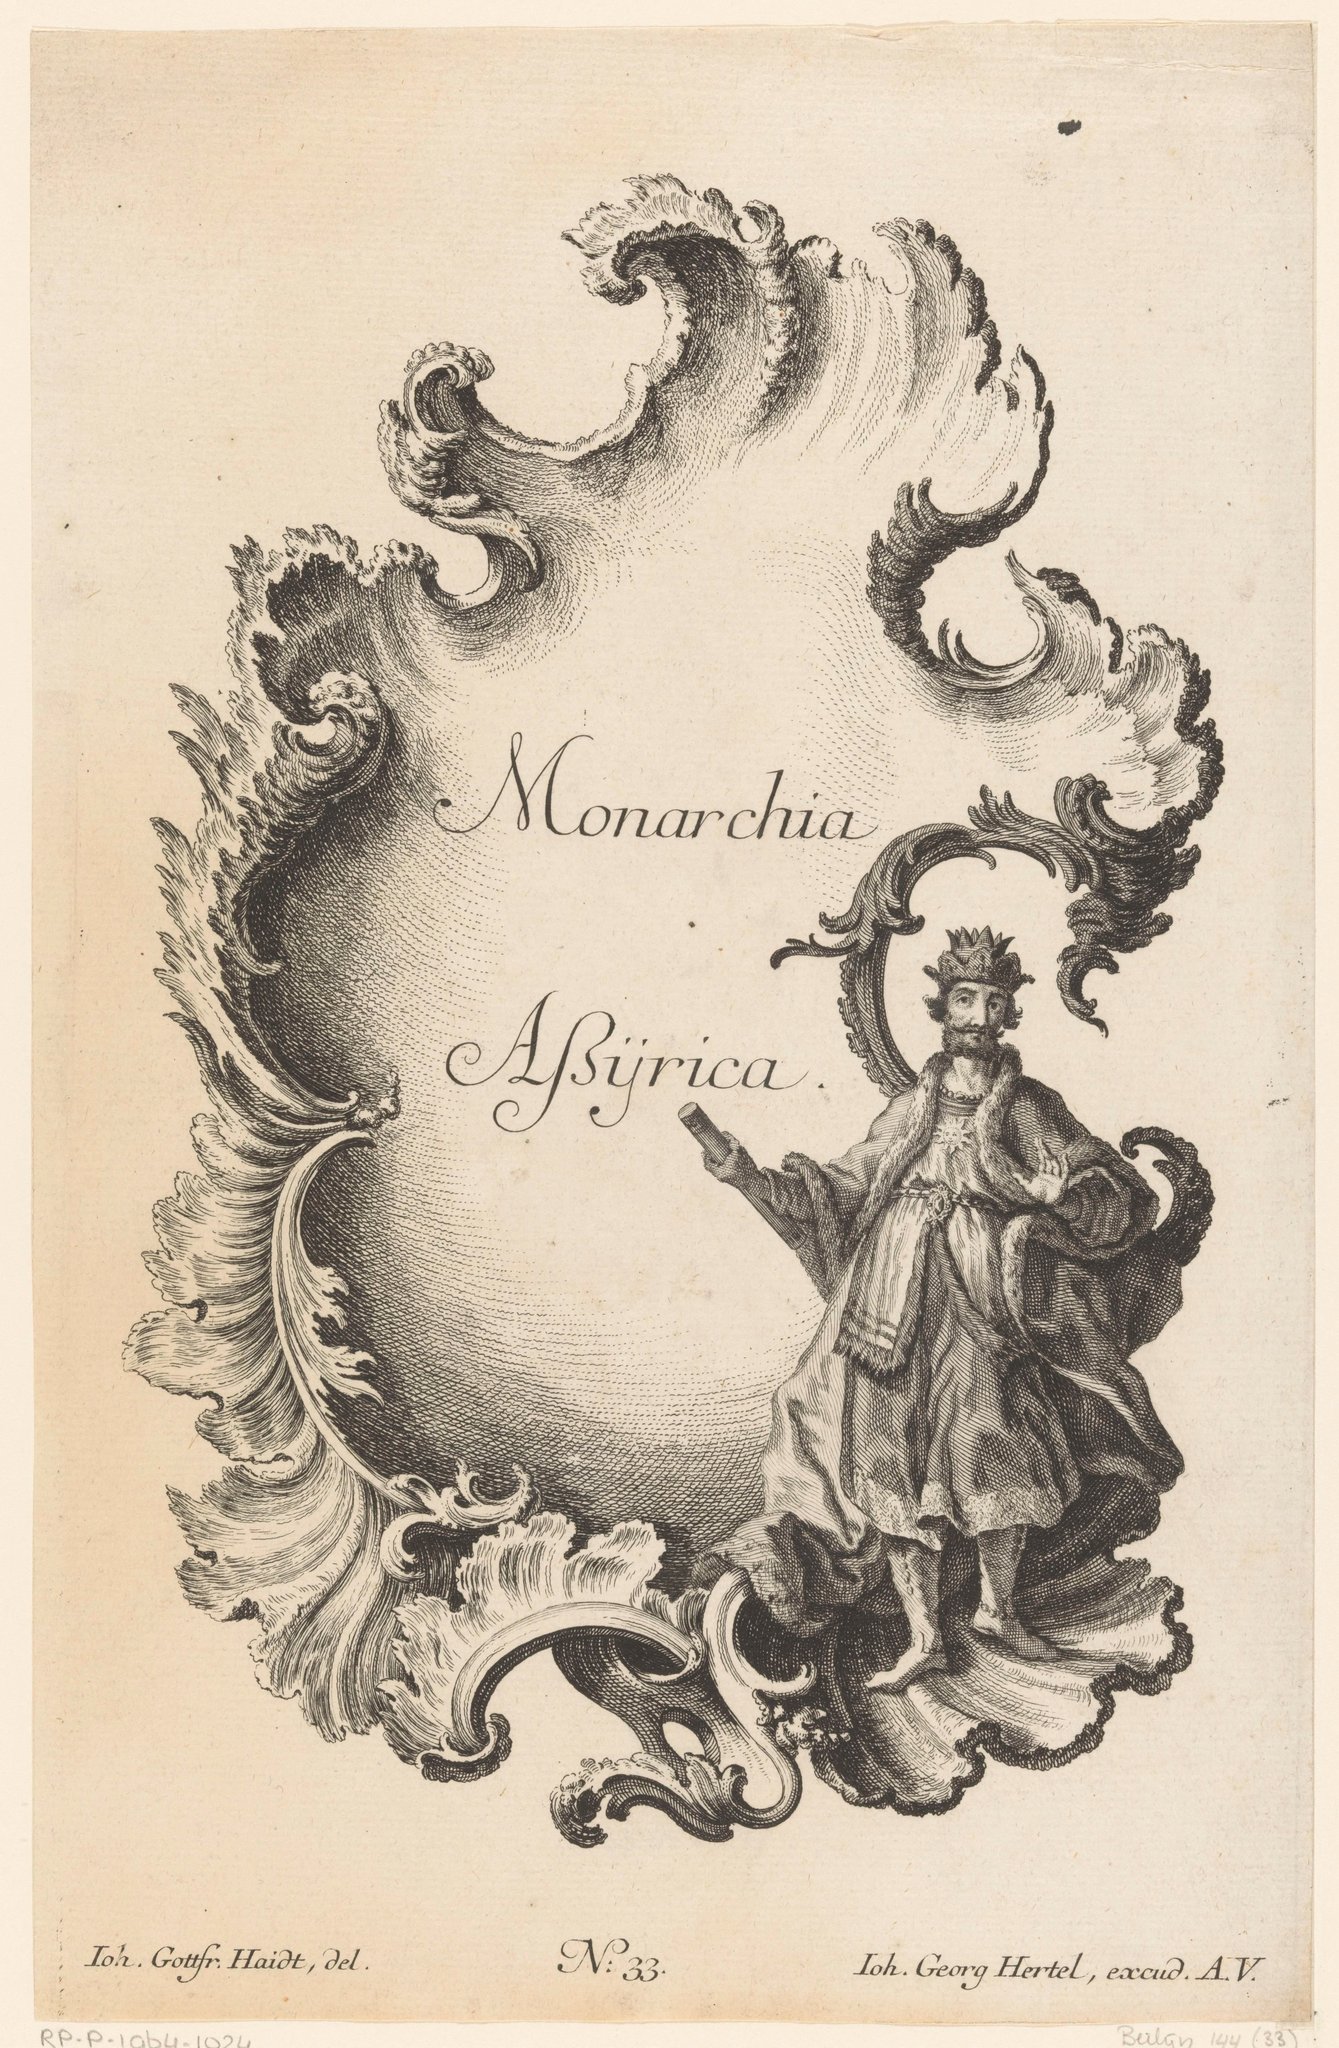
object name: print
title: Assyrische Rijk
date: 1745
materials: paper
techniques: etching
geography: augsburg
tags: babylon (one of the four world empires)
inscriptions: collector's mark: Lugt 2228, collector's mark: Lugt 2760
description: Personificatie van het Assyrische Rijk in een rocaille cartouche. Rechts staat een gekroonde man met snor en baard, in zijn rechterhand houdt hij een commandostaf. Uitgeversnummer 33.